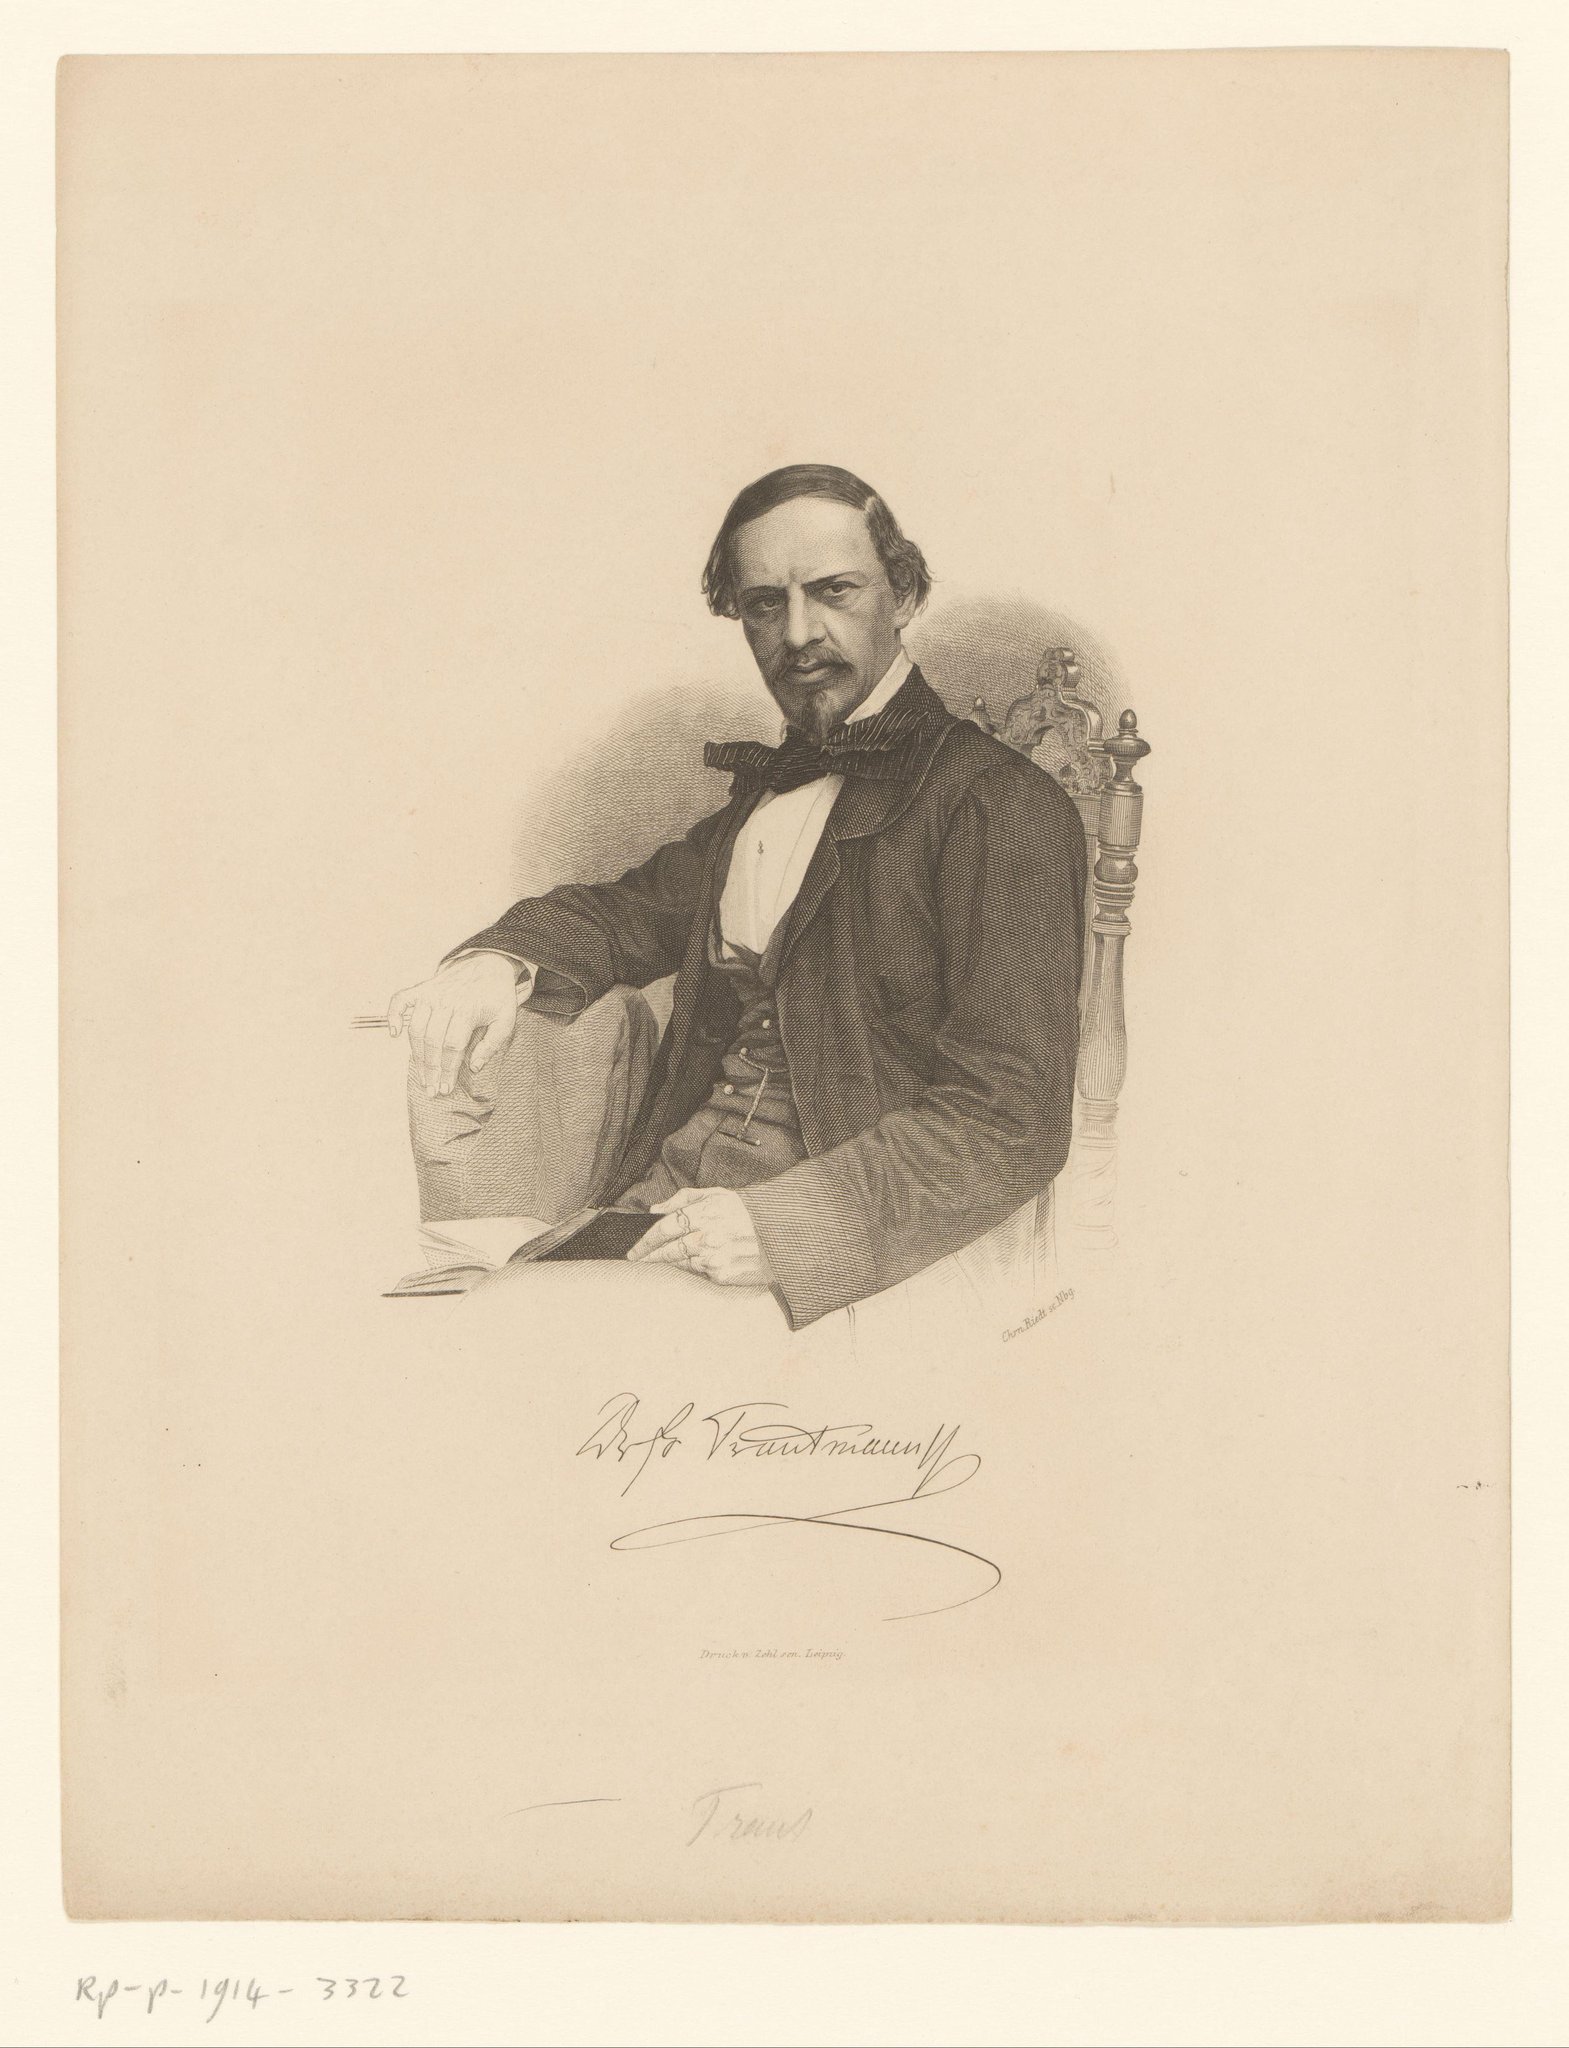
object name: print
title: Portret van Franz Trautmann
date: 1850-1914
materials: paper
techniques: engraving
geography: leipzig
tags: historical persons, book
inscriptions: collector's mark: Lugt 2228